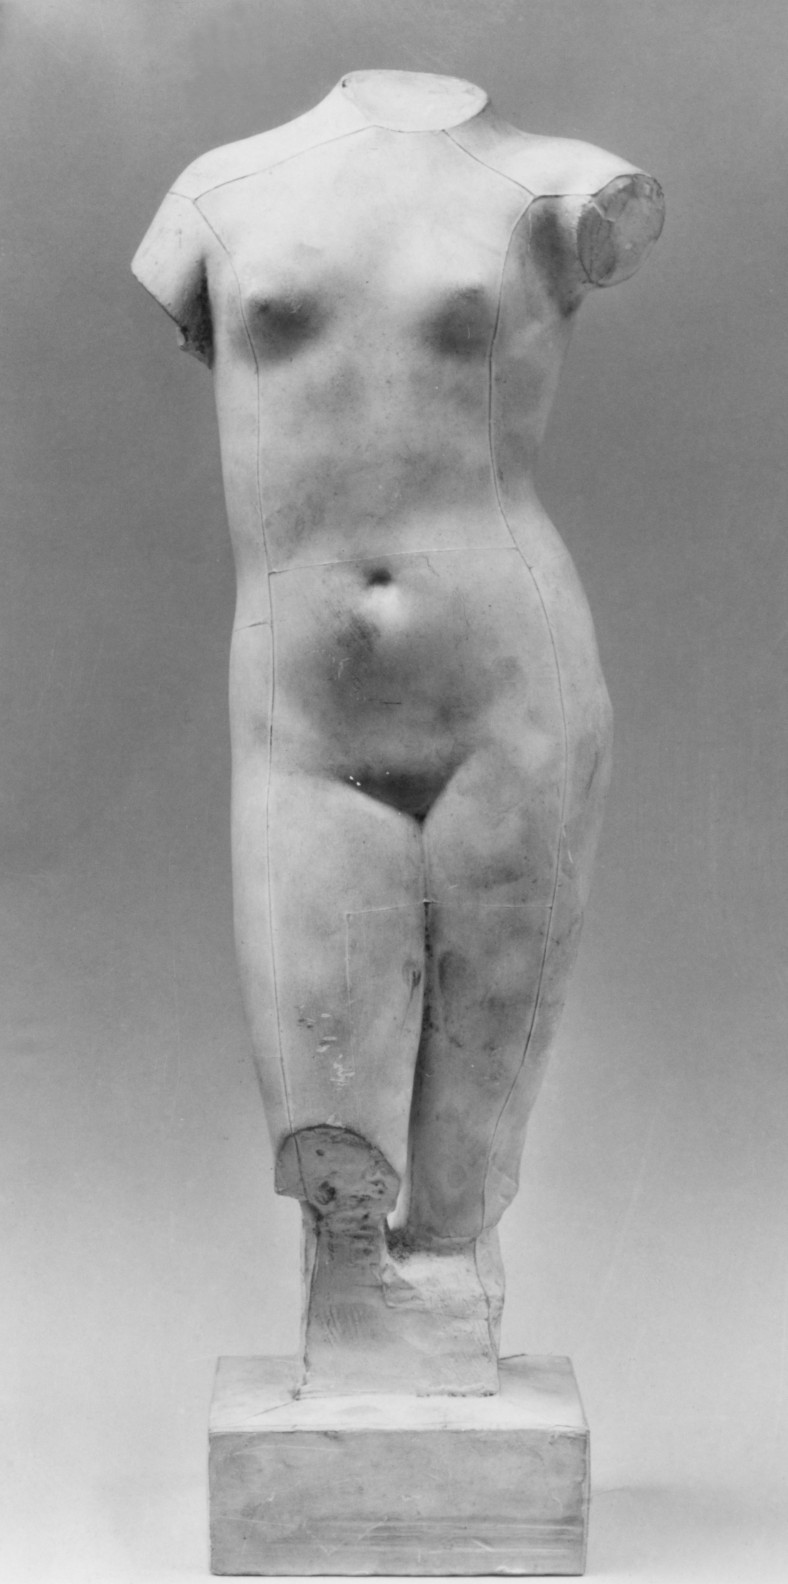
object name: statuette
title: Torso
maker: alphonse legros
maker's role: artist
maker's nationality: french and british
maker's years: 1837-1911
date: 1892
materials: plaster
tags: female nudes